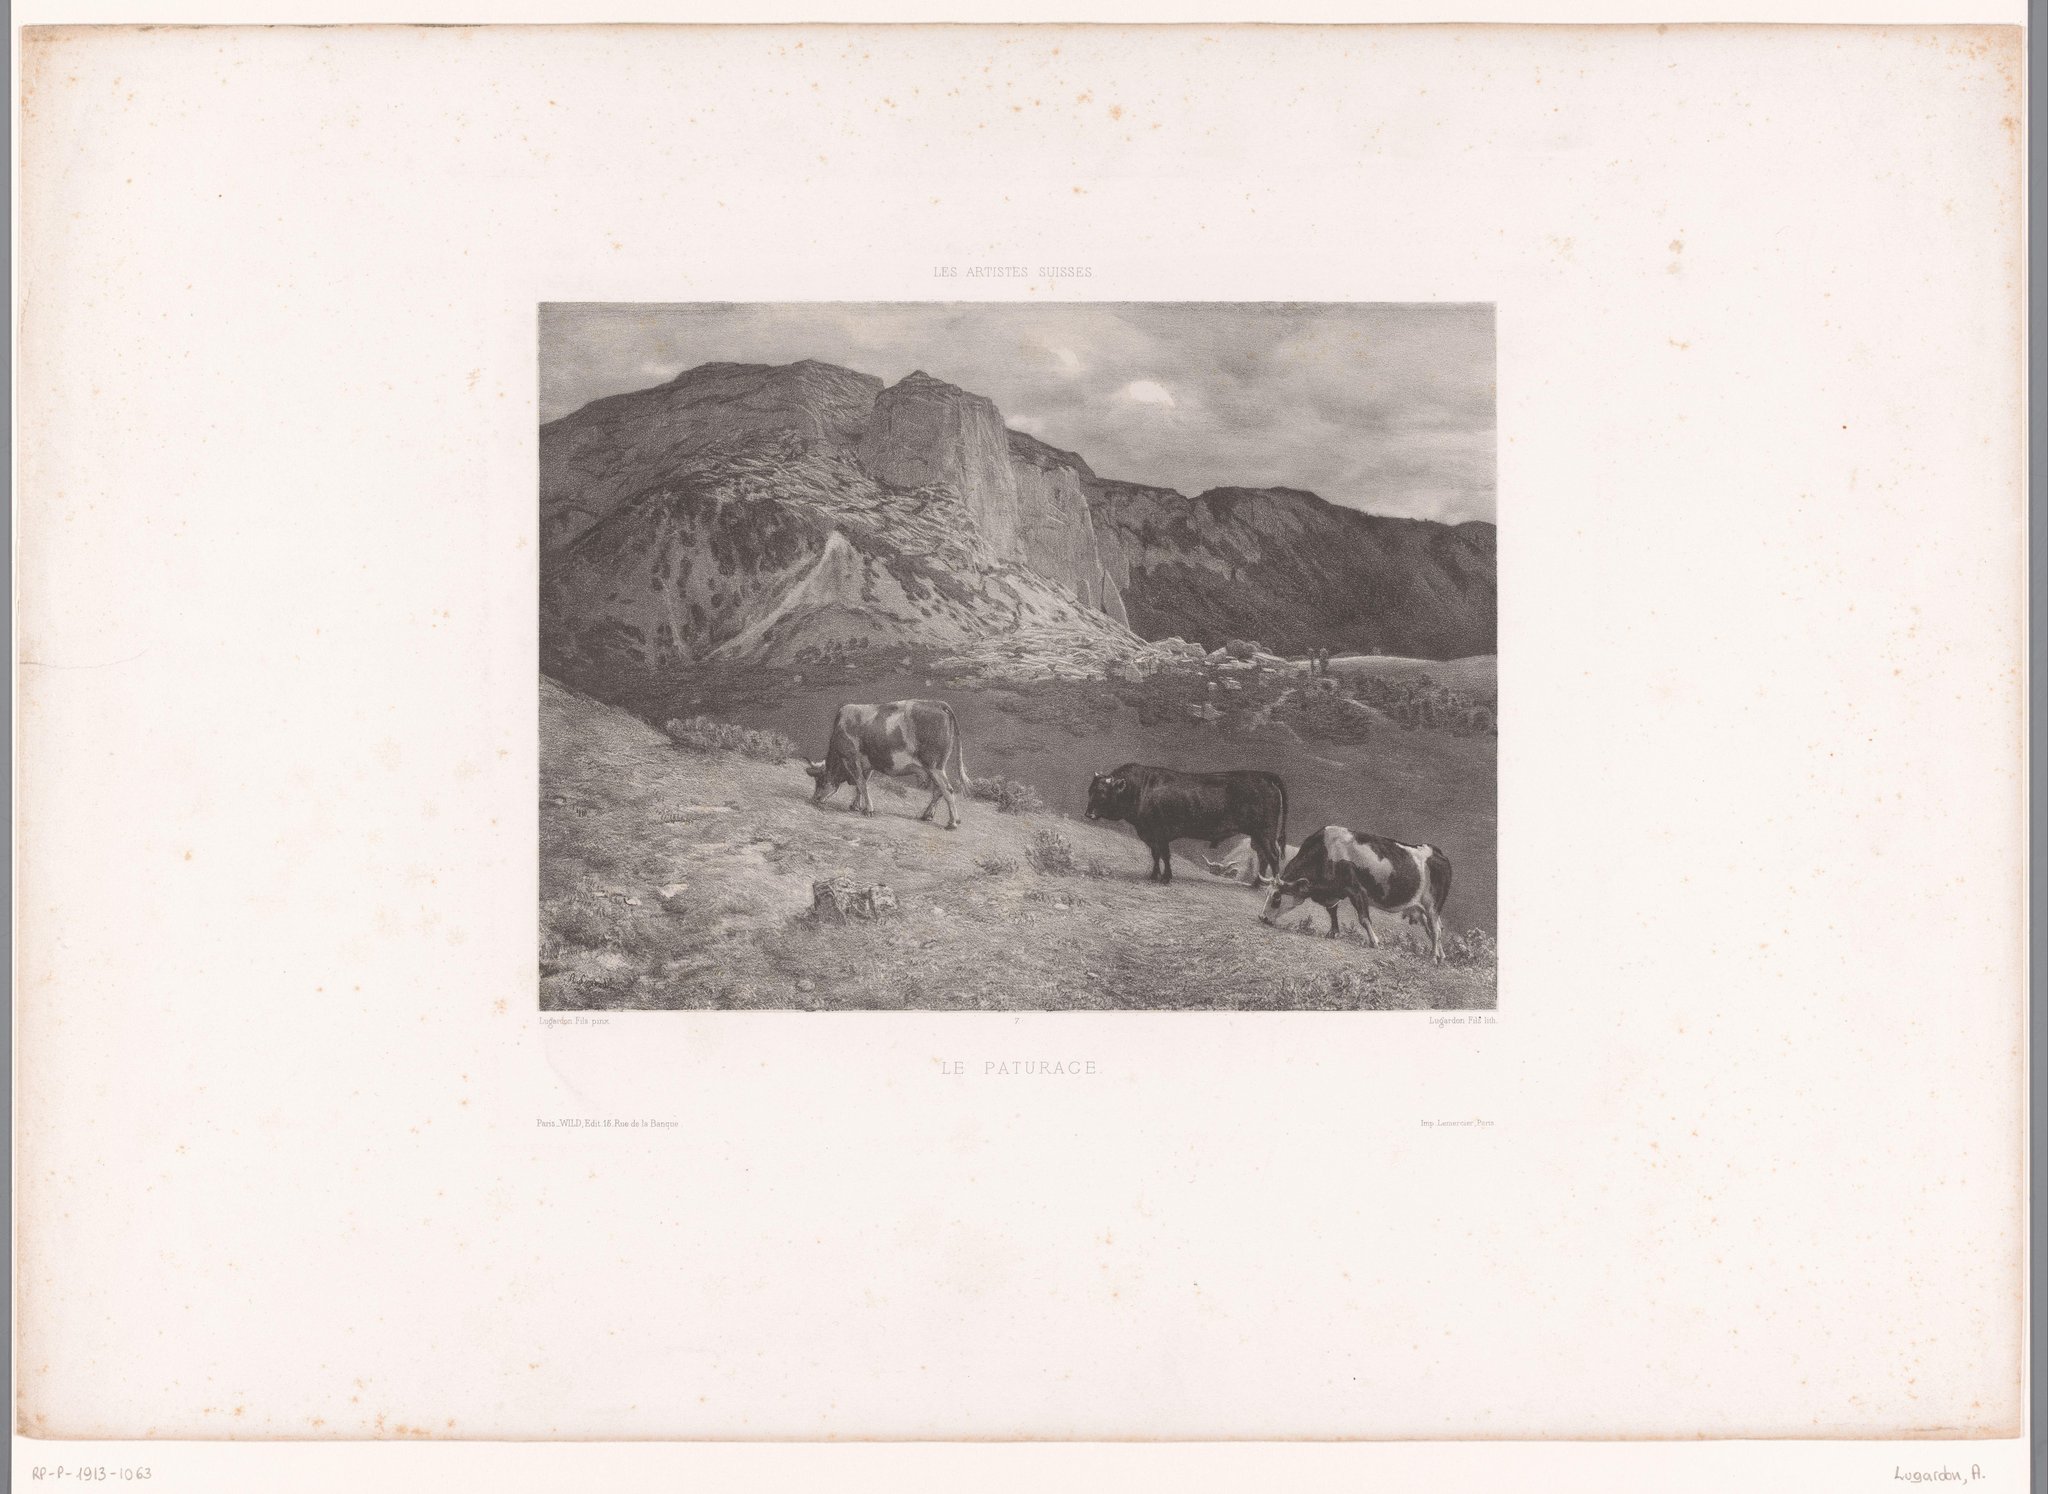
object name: print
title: Grazende koeien in een bergweide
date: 1852-1860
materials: paper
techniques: lithograph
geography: paris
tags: cow, cattle, mountain meadow, alp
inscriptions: collector's mark: Lugt 2228